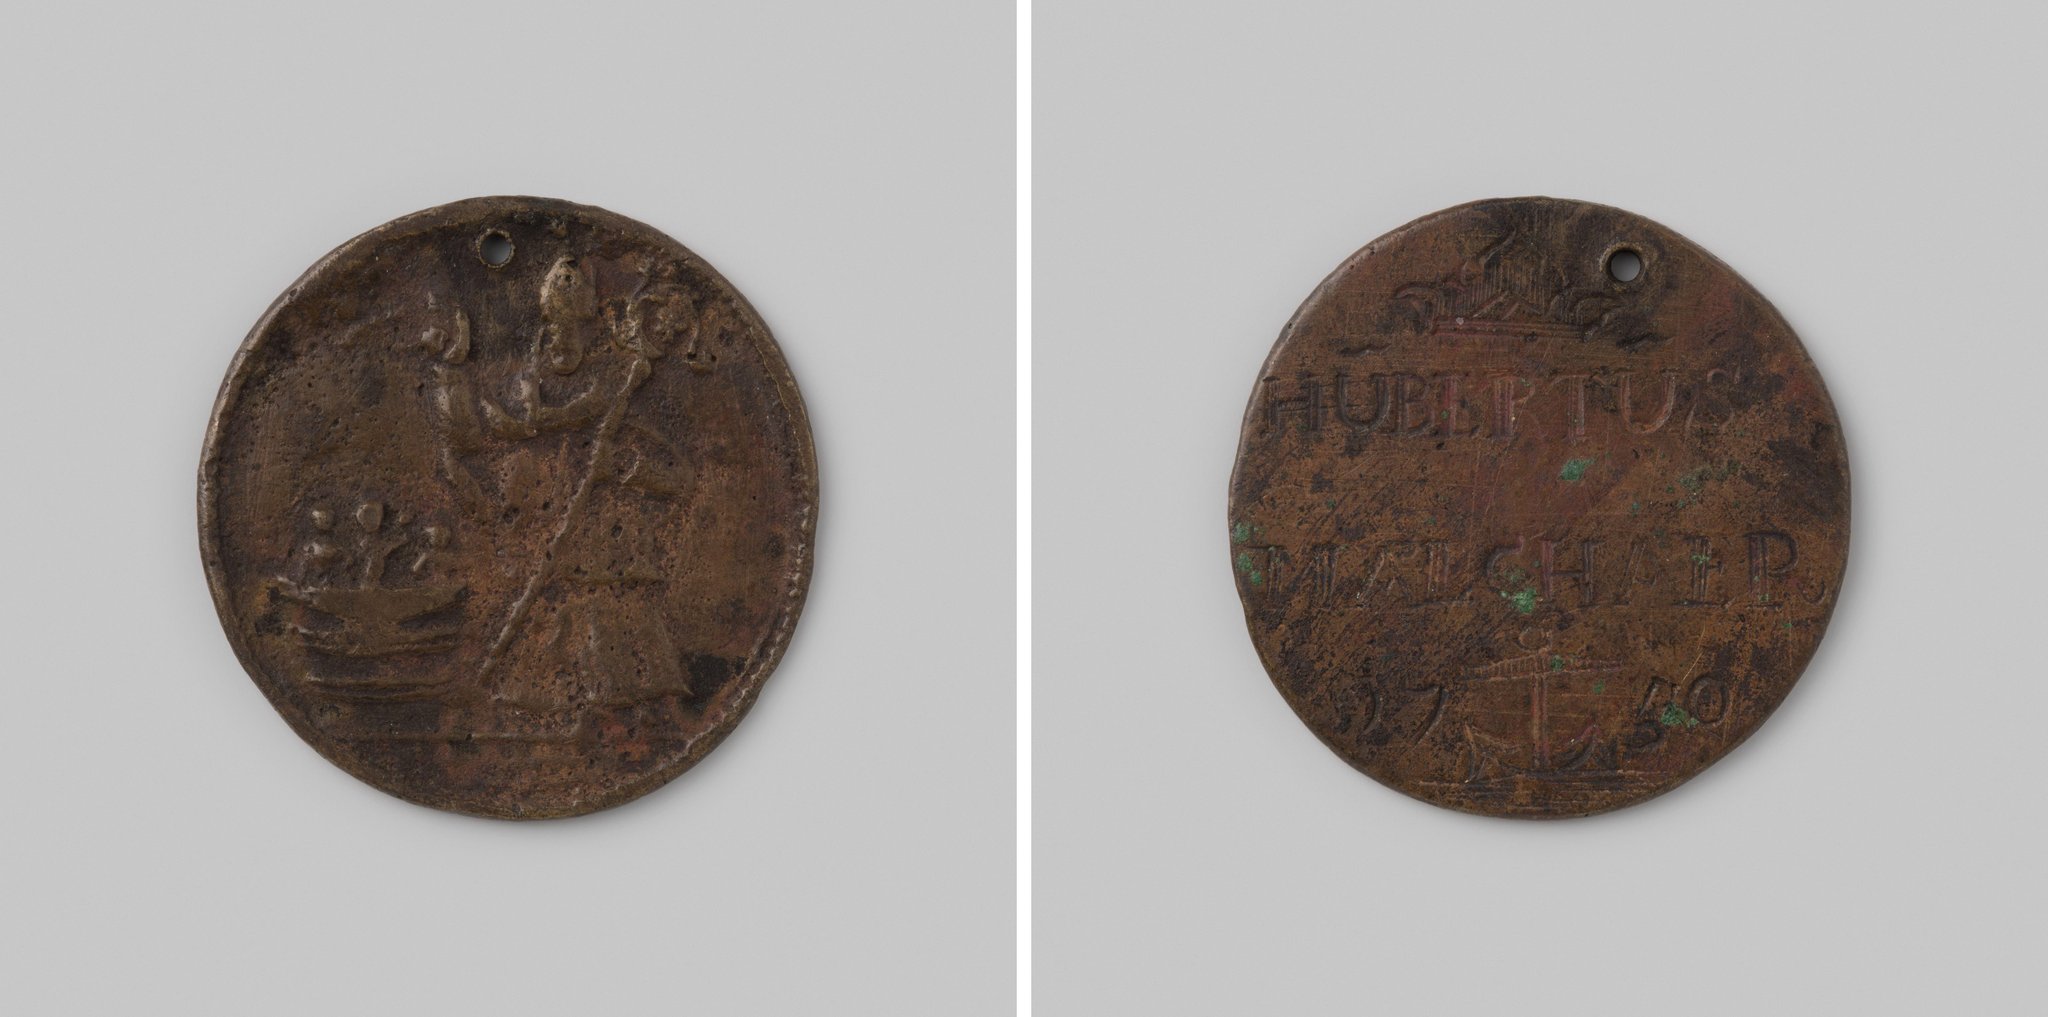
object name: medal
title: Presentiepenning van het Kramersgilde te Maastricht 1736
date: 1736-1750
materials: brass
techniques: casting, engraving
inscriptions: inscription: ‘(kroon) / HUBERTUS / MALCHAER / 17 (anker) 50’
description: Gegoten messing penning, op de voorzijde Sint Nicolaas zegenend bij een ton met drie kinderen, op de gladgemaakte keerzijde gegraveerd twee regels tekst tussen een kroon en een anker, op naam van Hubertus Malchaer 1750, met draaggat